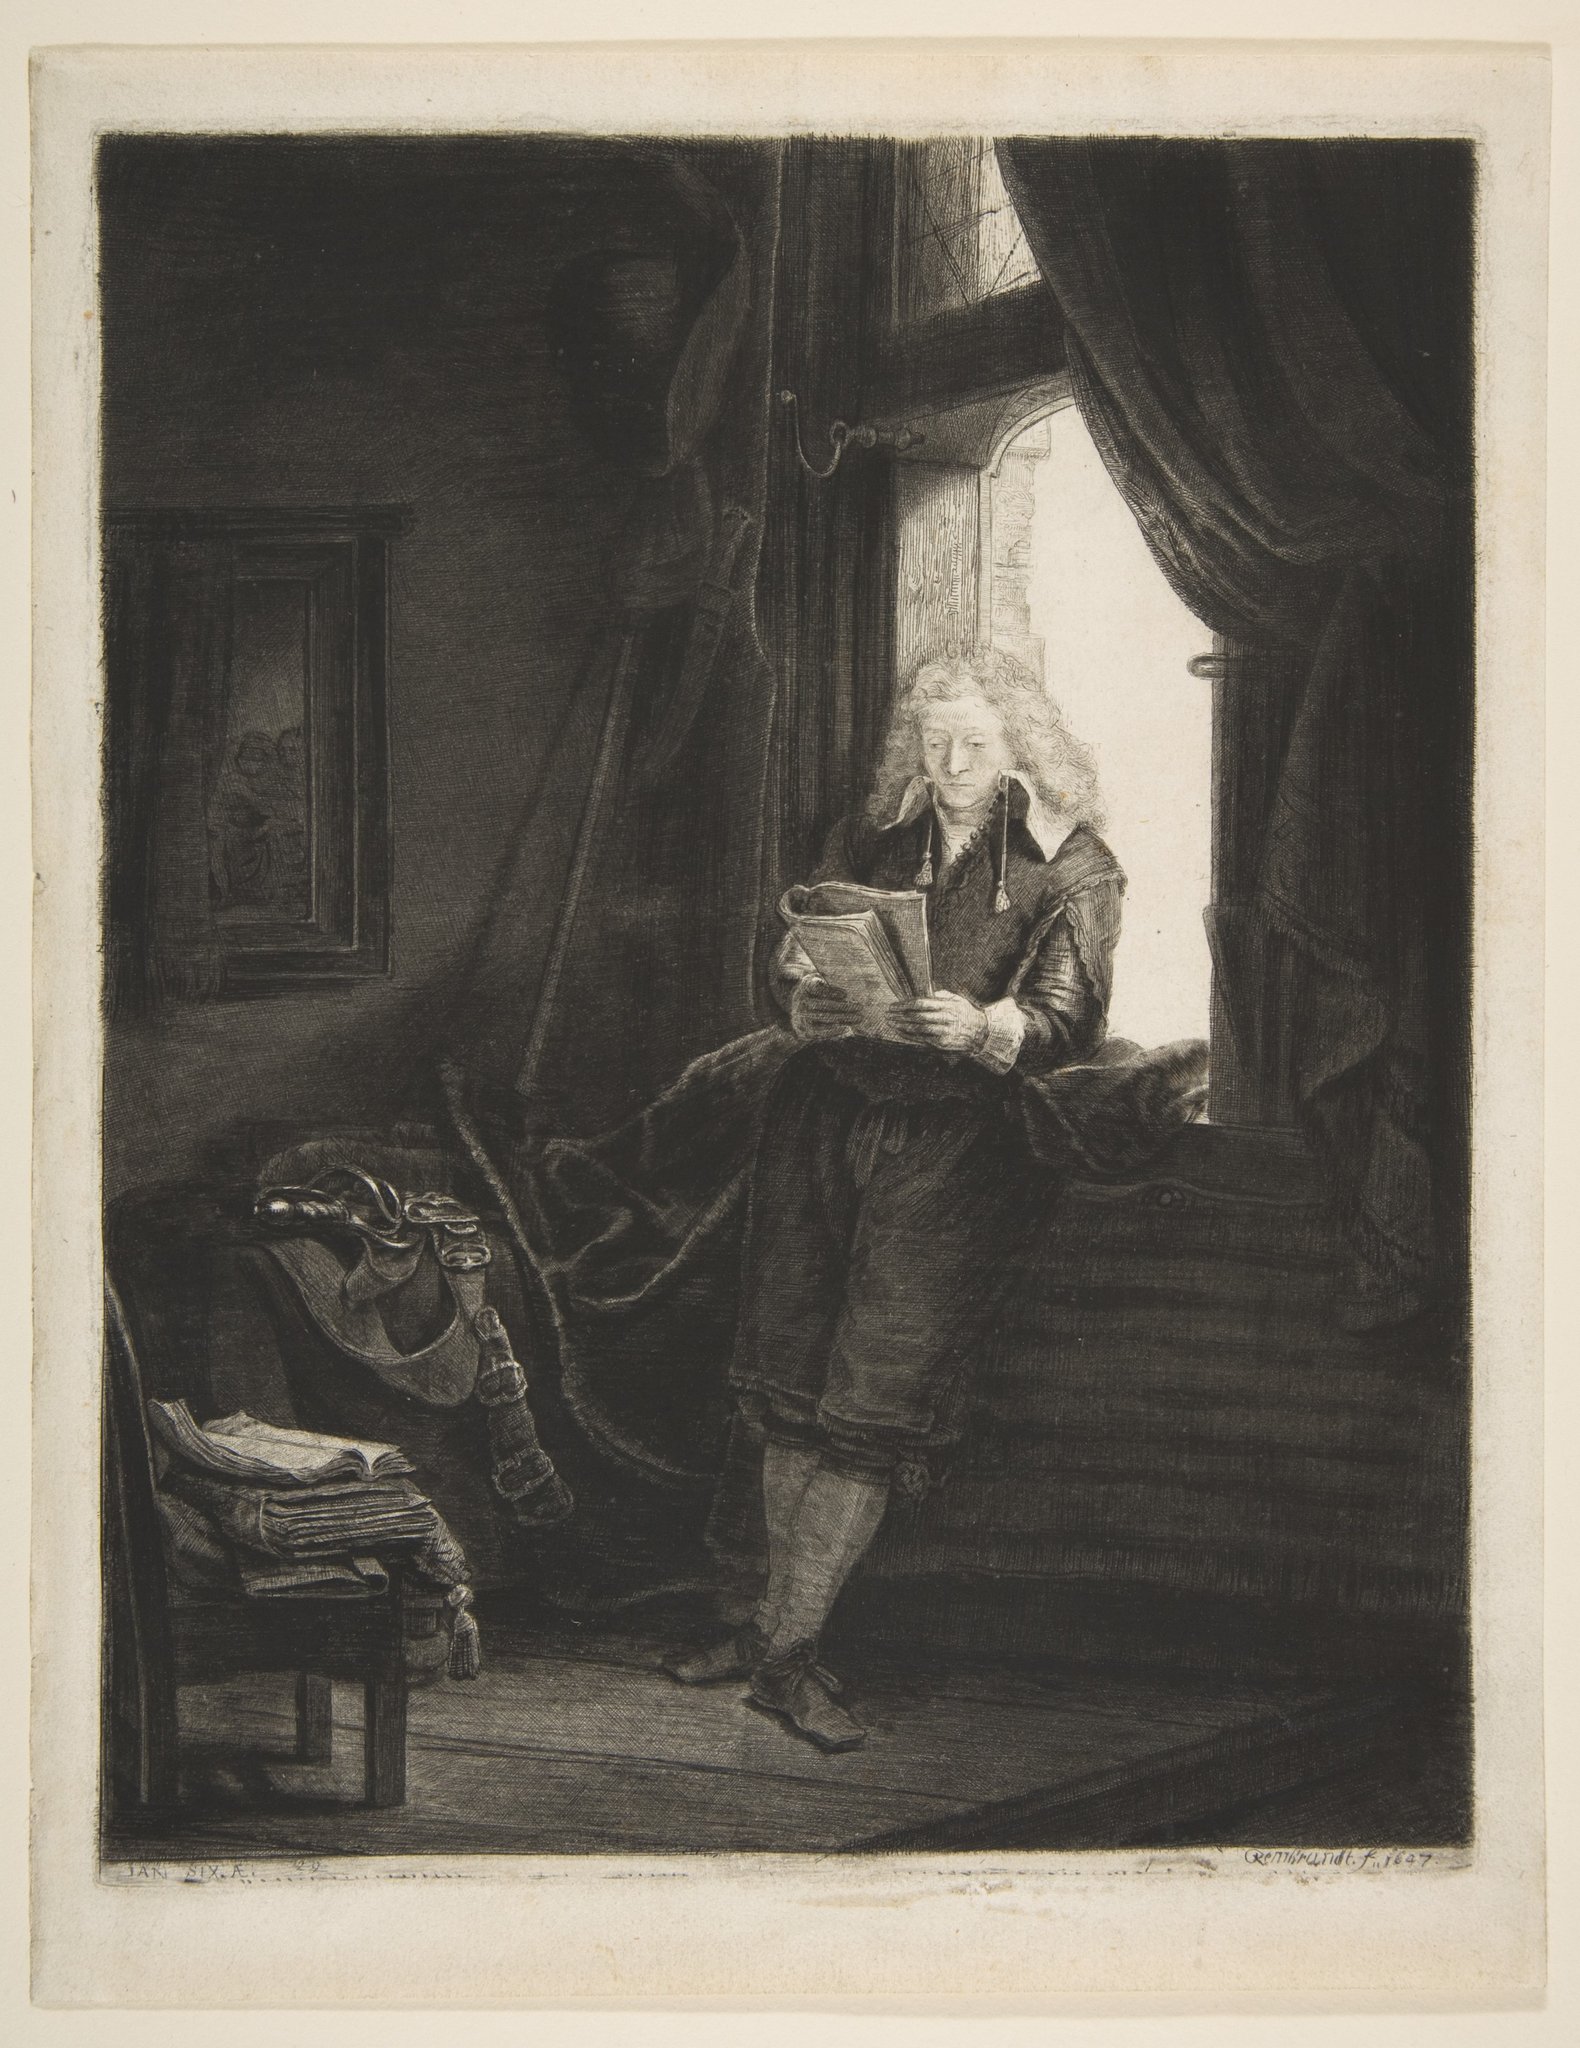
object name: print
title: Jan Six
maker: rembrandt van rijn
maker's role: artist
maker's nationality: dutch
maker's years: 1606-1669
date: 1647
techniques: engraving, drypoint, etching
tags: men,reading